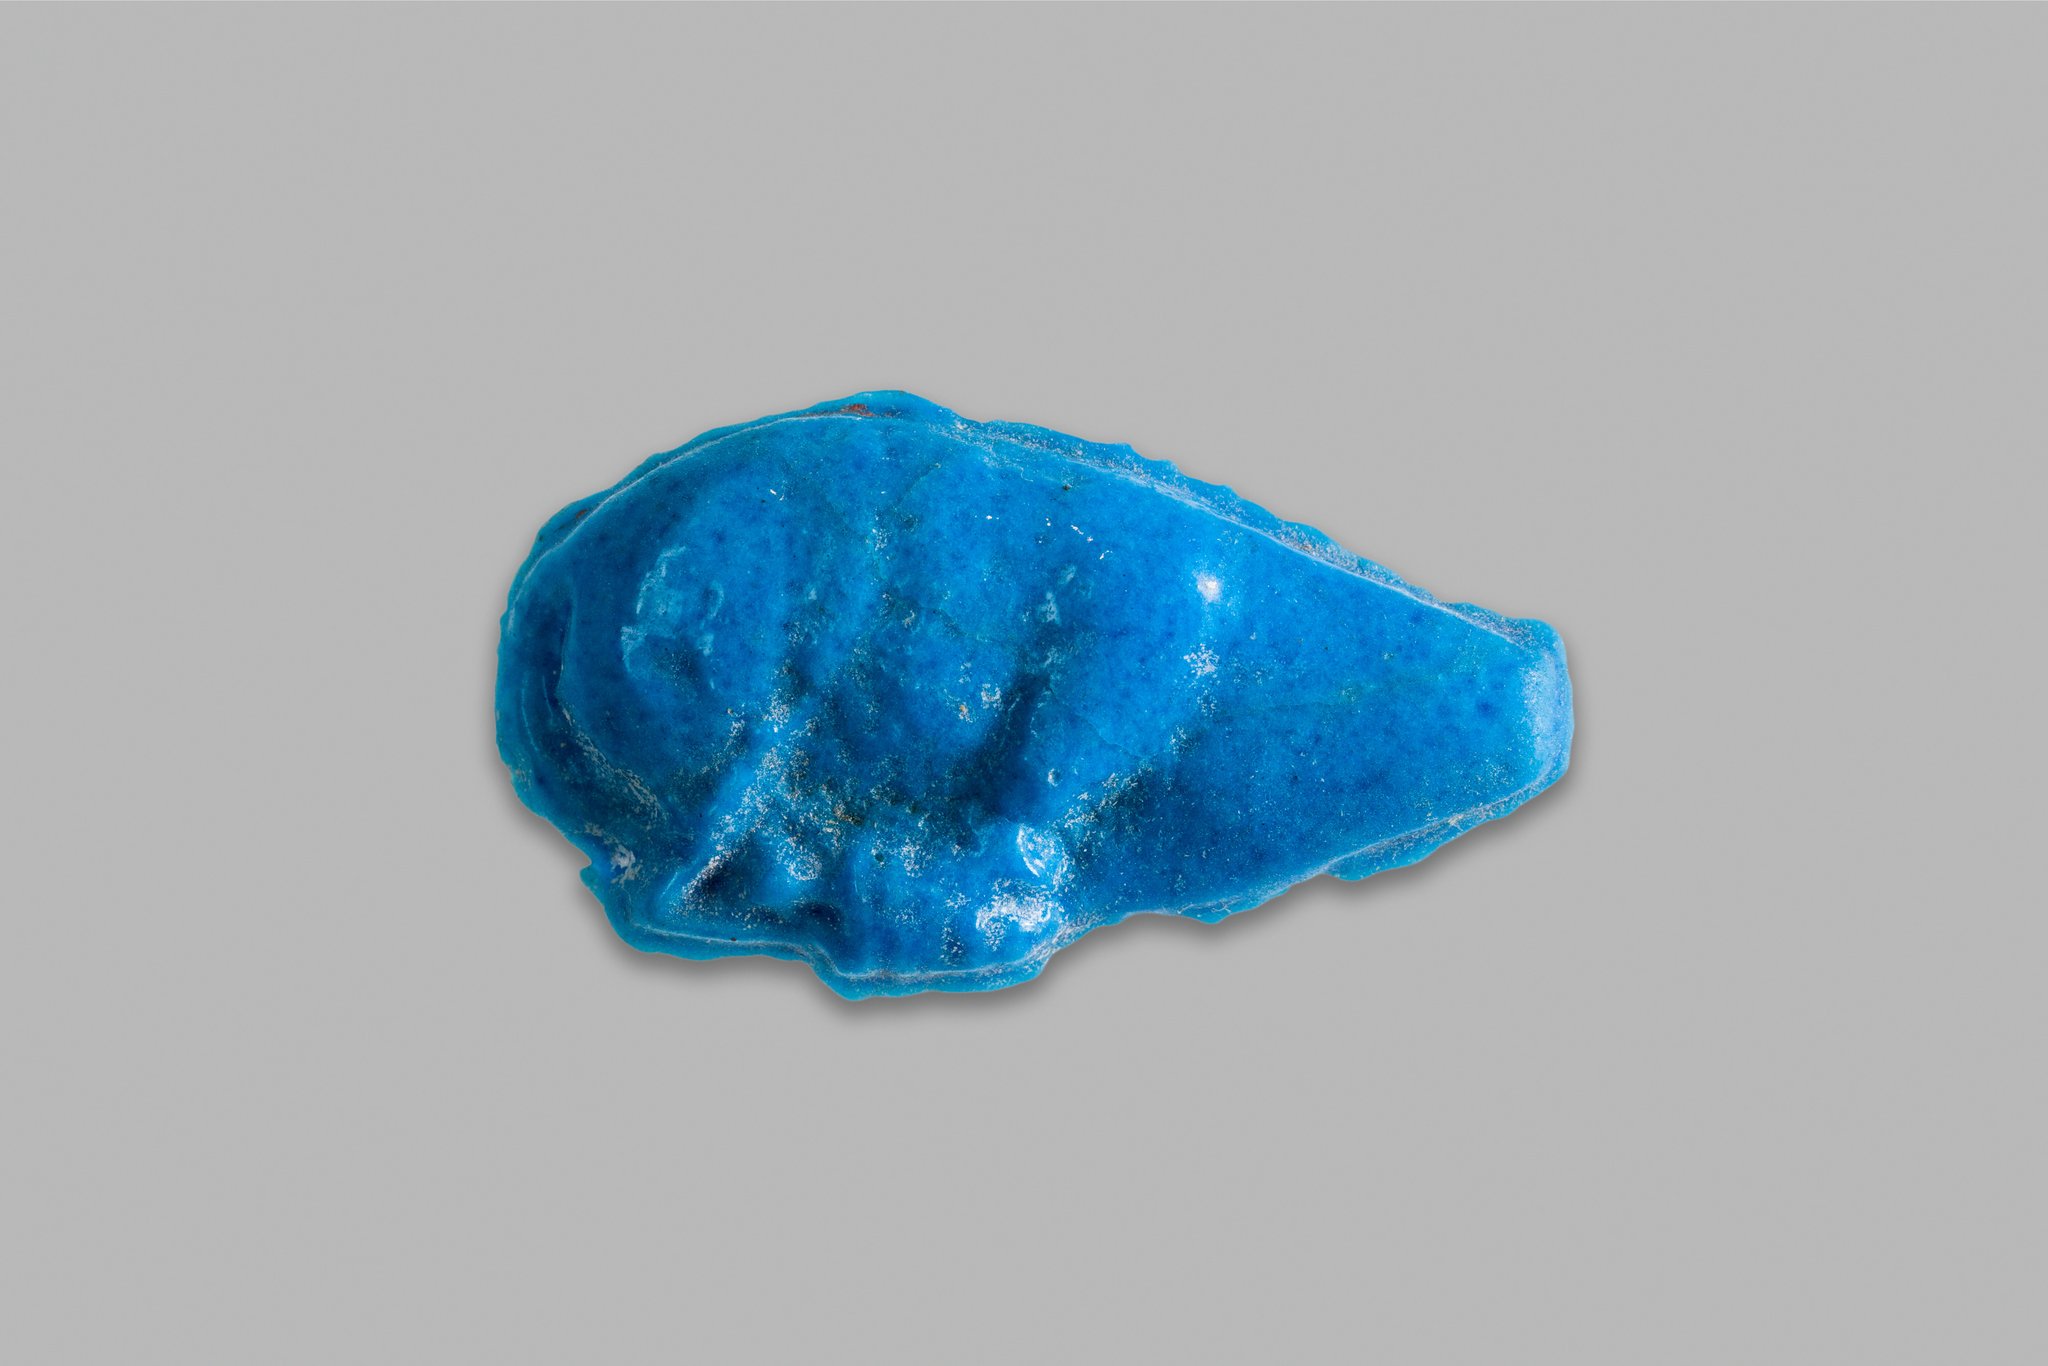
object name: foundation deposit plaque, slaughtered ox, ramesses iv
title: Plaque in the Form of a Slaughtered Ox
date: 1153-1147 BCE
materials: faience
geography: egypt